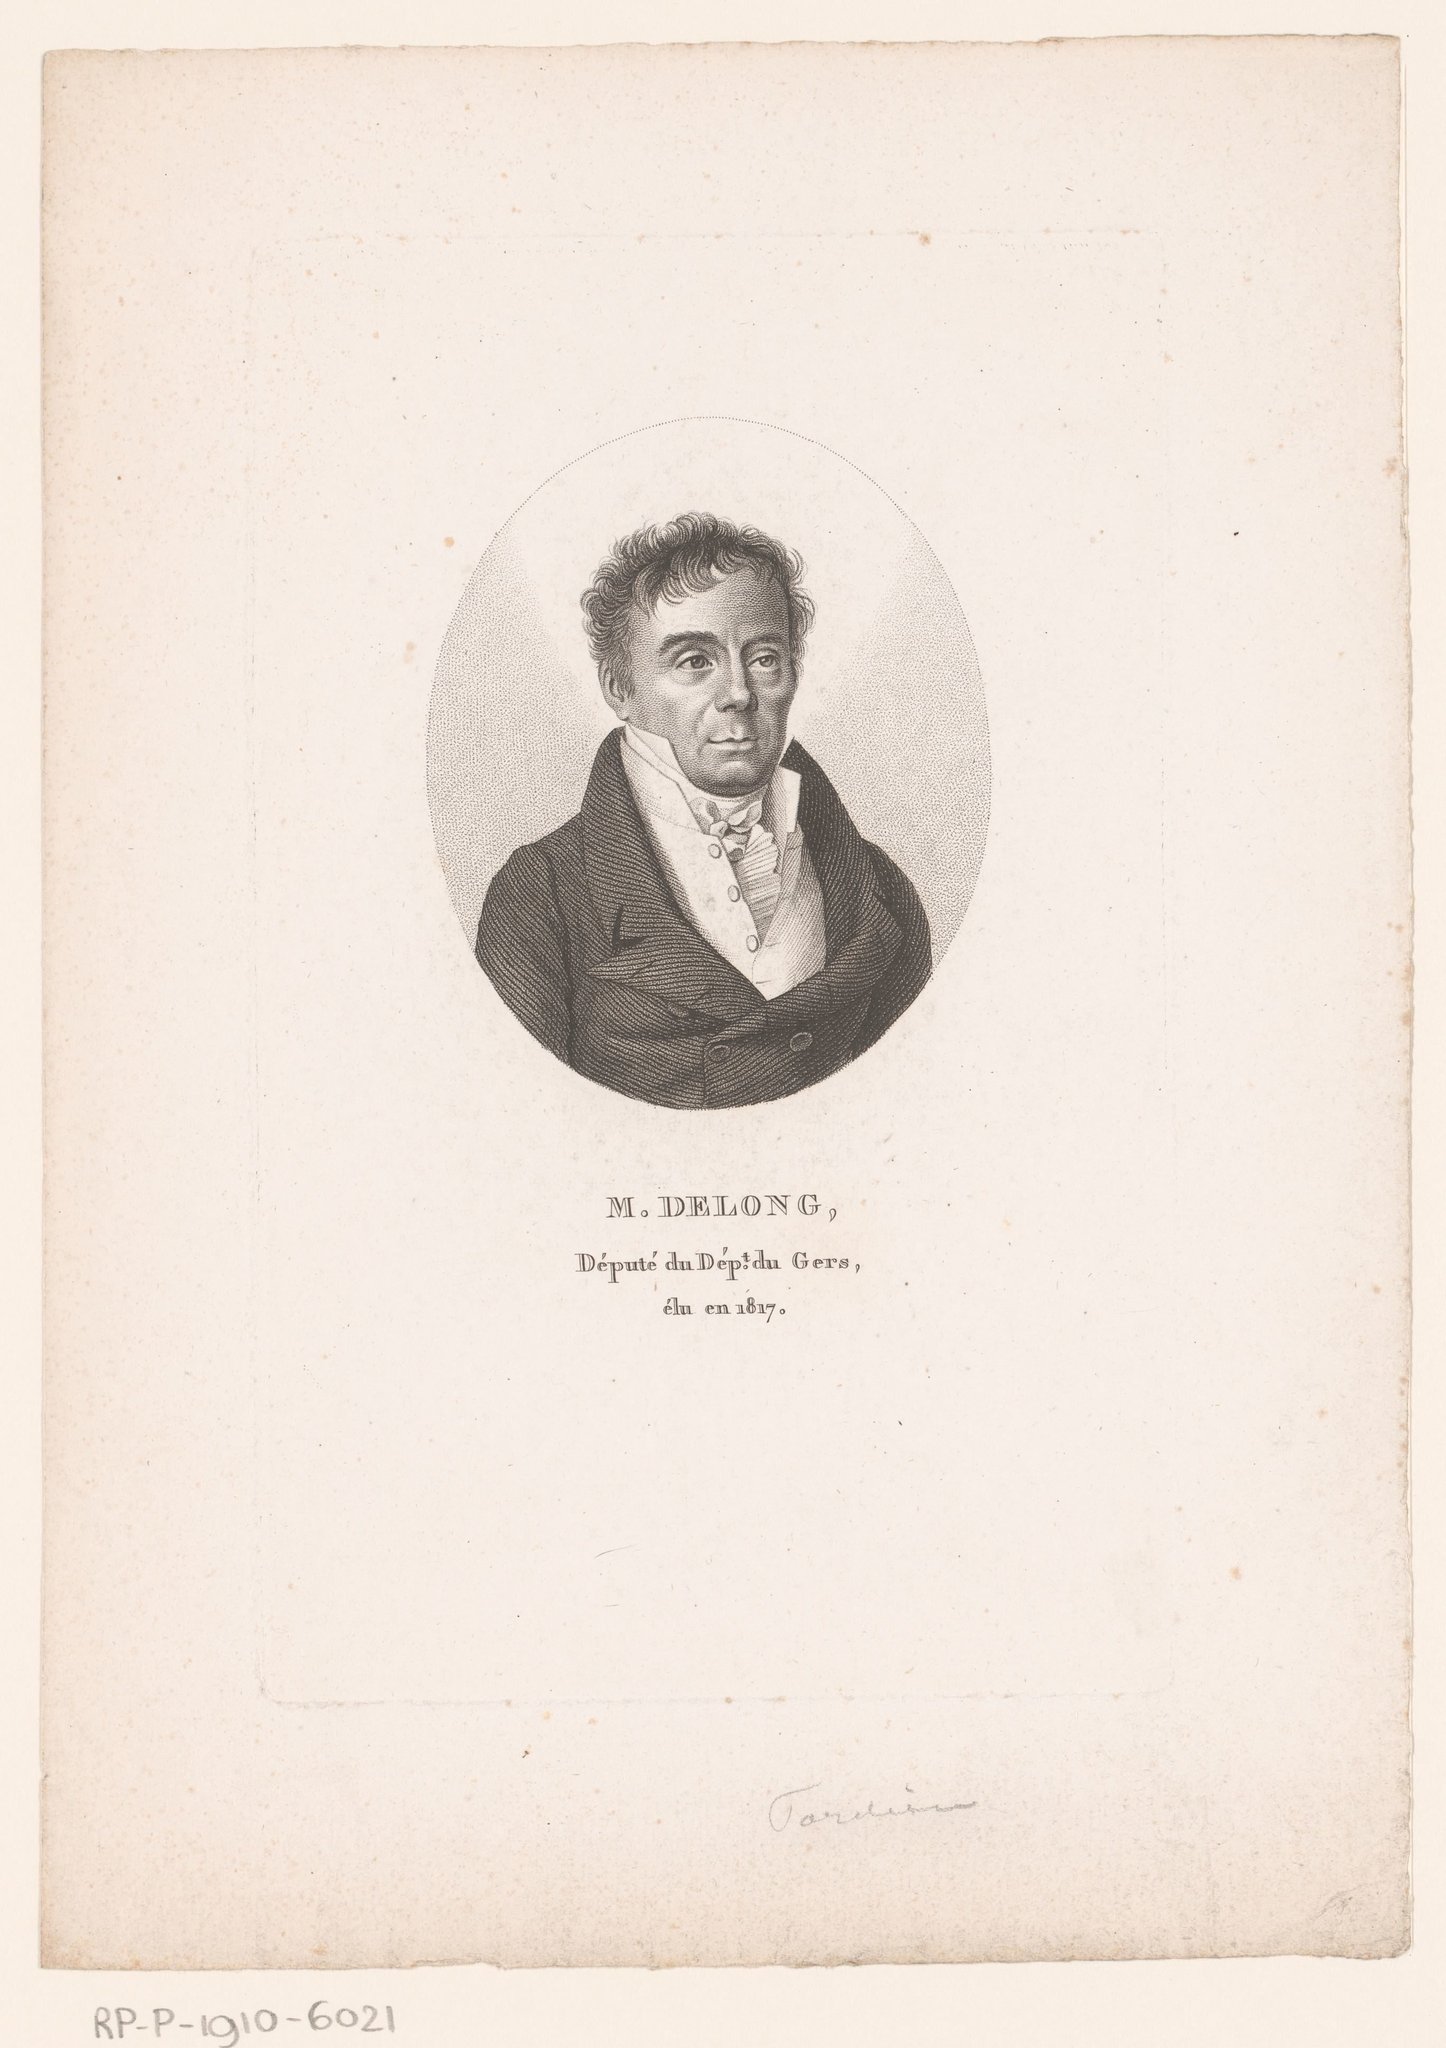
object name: print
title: Portret van Jean-Baptiste Delong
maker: ambroise tardieu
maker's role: print maker, printer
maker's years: 1788-1841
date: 1820-1821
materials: paper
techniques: engraving, roulette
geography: paris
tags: politician, historical persons, politician, e.g. party leader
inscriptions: collector's mark: Lugt 2228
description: Prent uit: Tardieu, Ambroise. Portraits des députés, écrivains et pairs constitutionnels, défenseurs invariables de la charte et de la loi des élections du 5 février 1817. Parijs: Tardieu, Ambroise, 1820-1821.